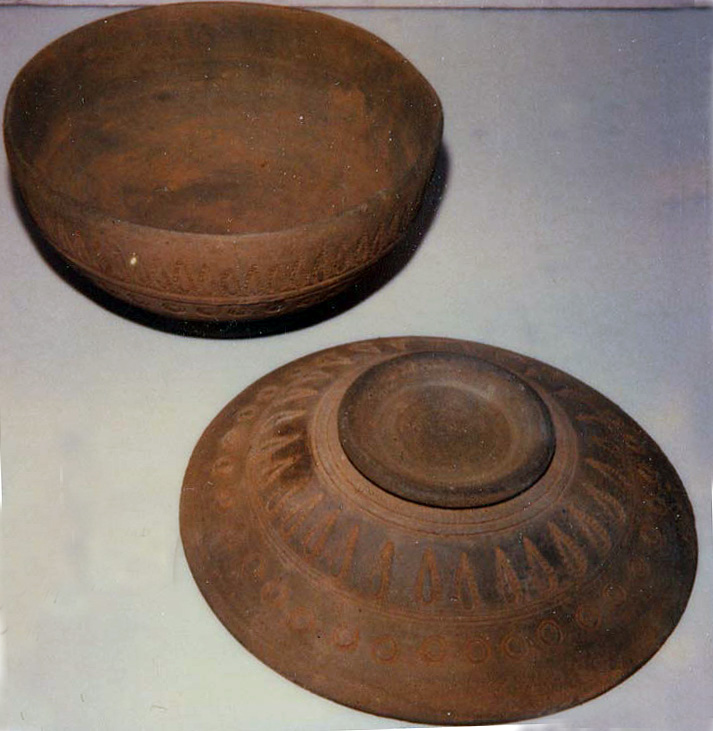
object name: bowl with cover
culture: korean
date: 401-700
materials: porcelain, pottery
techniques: firing